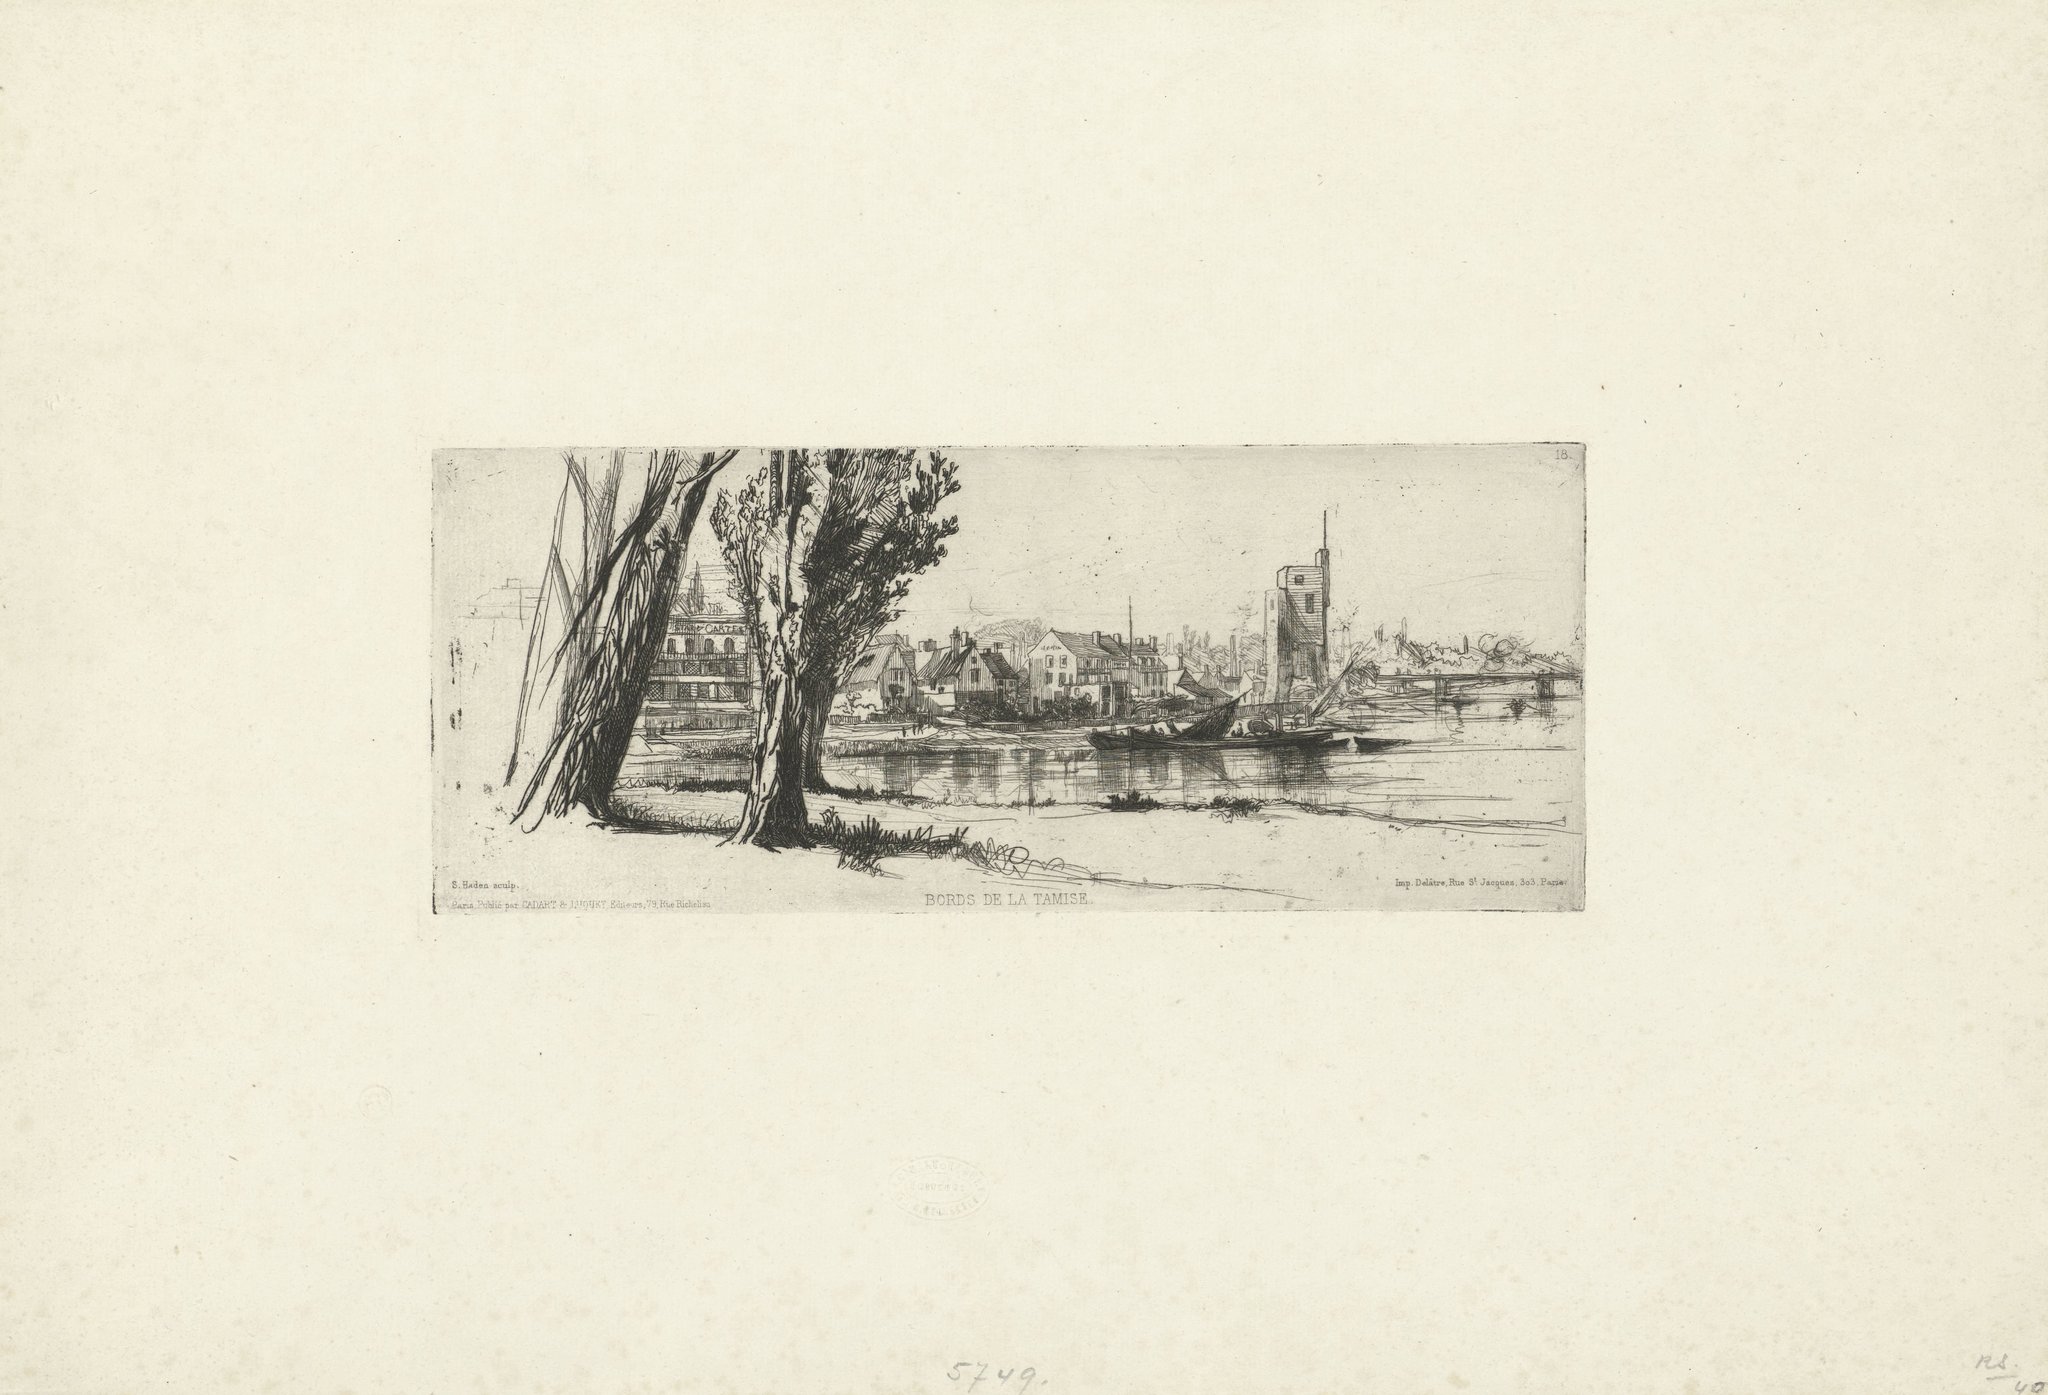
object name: print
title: Bords de la Tamise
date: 1859-1861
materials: paper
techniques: drypoint, etching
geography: paris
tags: village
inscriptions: collector's mark: Lugt 424, collector's mark, collector's mark: Lugt 2228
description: Het dorp Fulham aan de oever van de rivier de Theems.